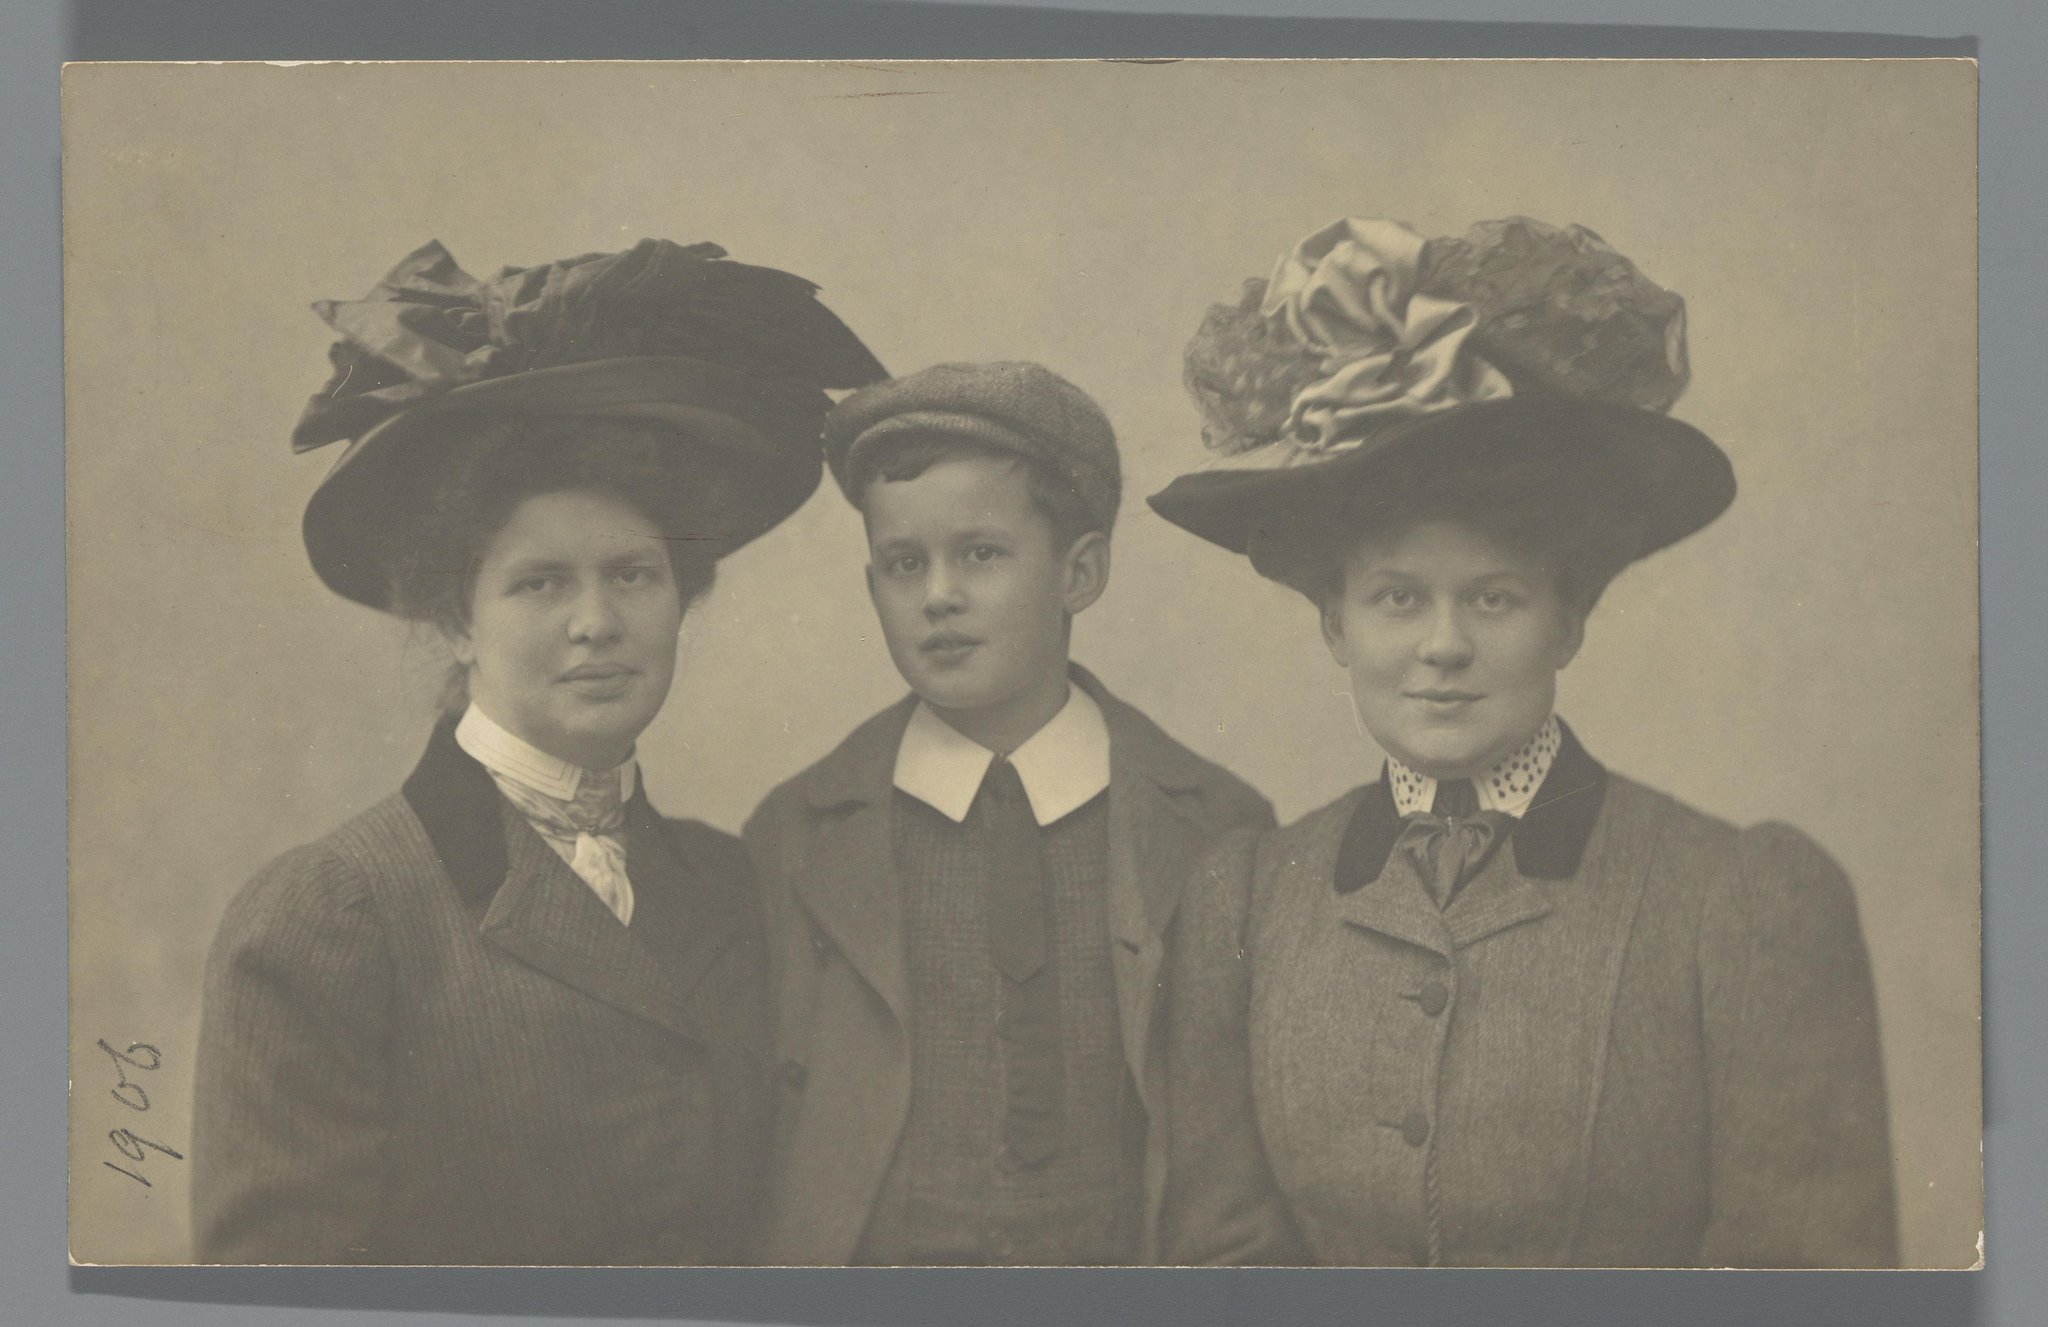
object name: ansichtkaart, prentbriefkaart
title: Portret van tante Leo, Jan van Lier en Line van den Berg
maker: Anonymous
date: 1906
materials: photographic support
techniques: photography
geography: netherlands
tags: the hague, caroline louise van den berg-van den berg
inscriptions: date: ‘1906’, inscription: ‘tante Leo . Moeder / en Jan v. Lier 1906?’